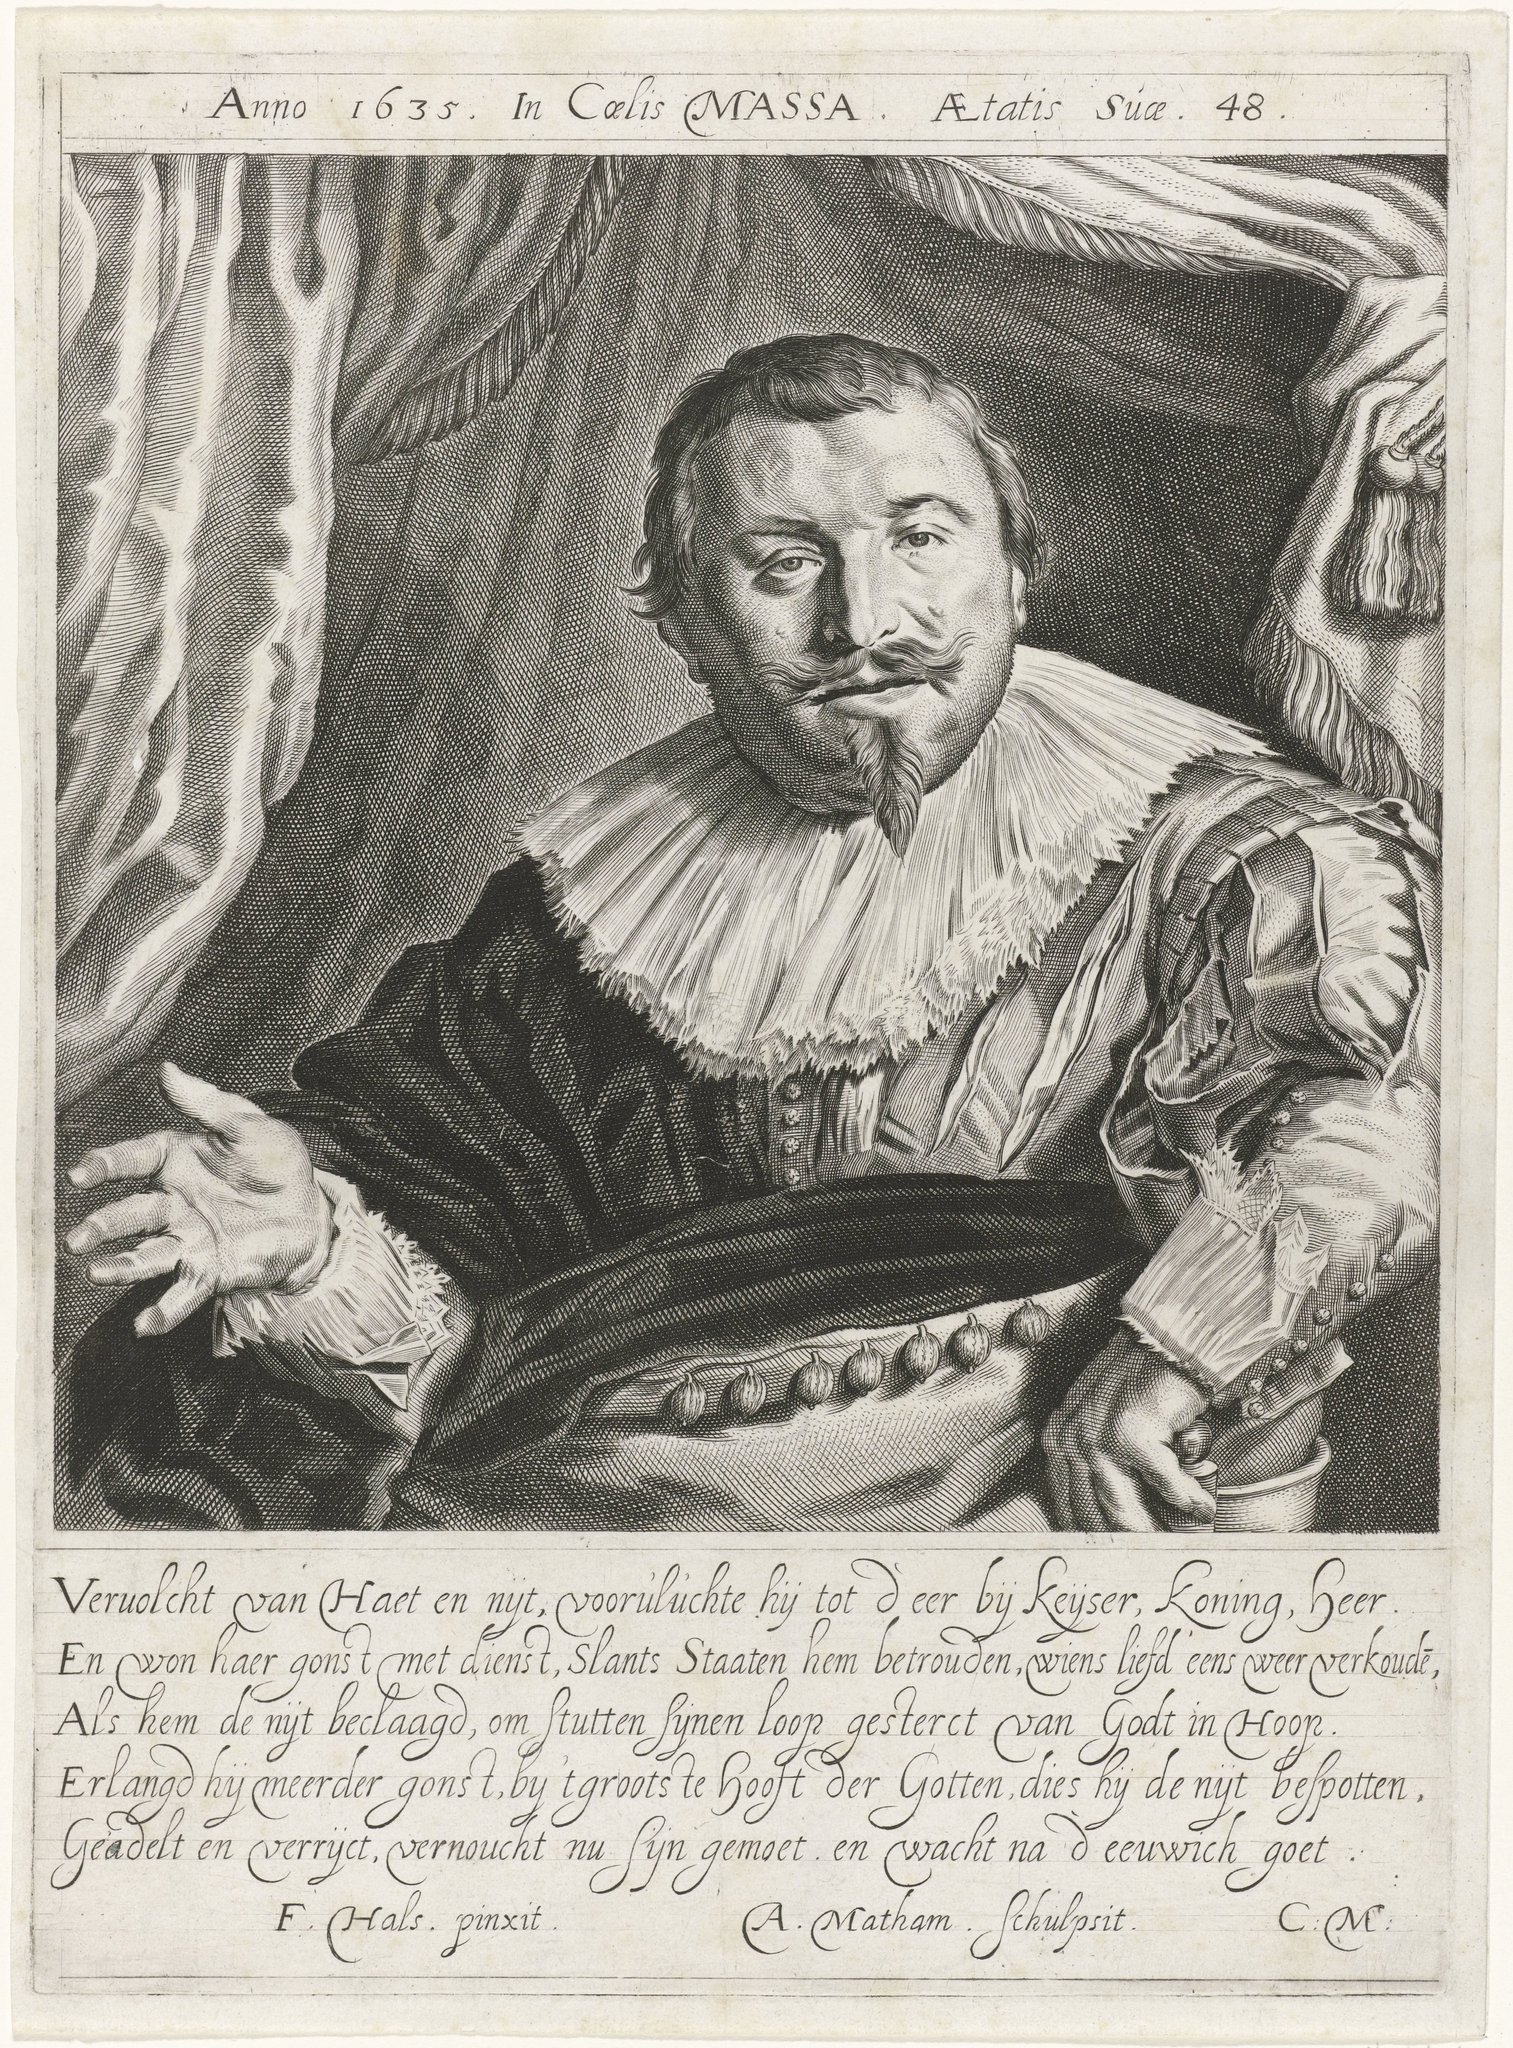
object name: print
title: Portret van Isaac Abrahamsz. Massa op 48-jarige leeftijd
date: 1635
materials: paper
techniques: engraving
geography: haarlem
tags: diplomaat, handelaar, landkaartenmaker, isaac abrahamsz. massa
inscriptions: collector's mark: Lugt 964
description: Portret van de handelaar en diplomaat Isaac Abrahamsz. Massa op 48-jarige leeftijd.